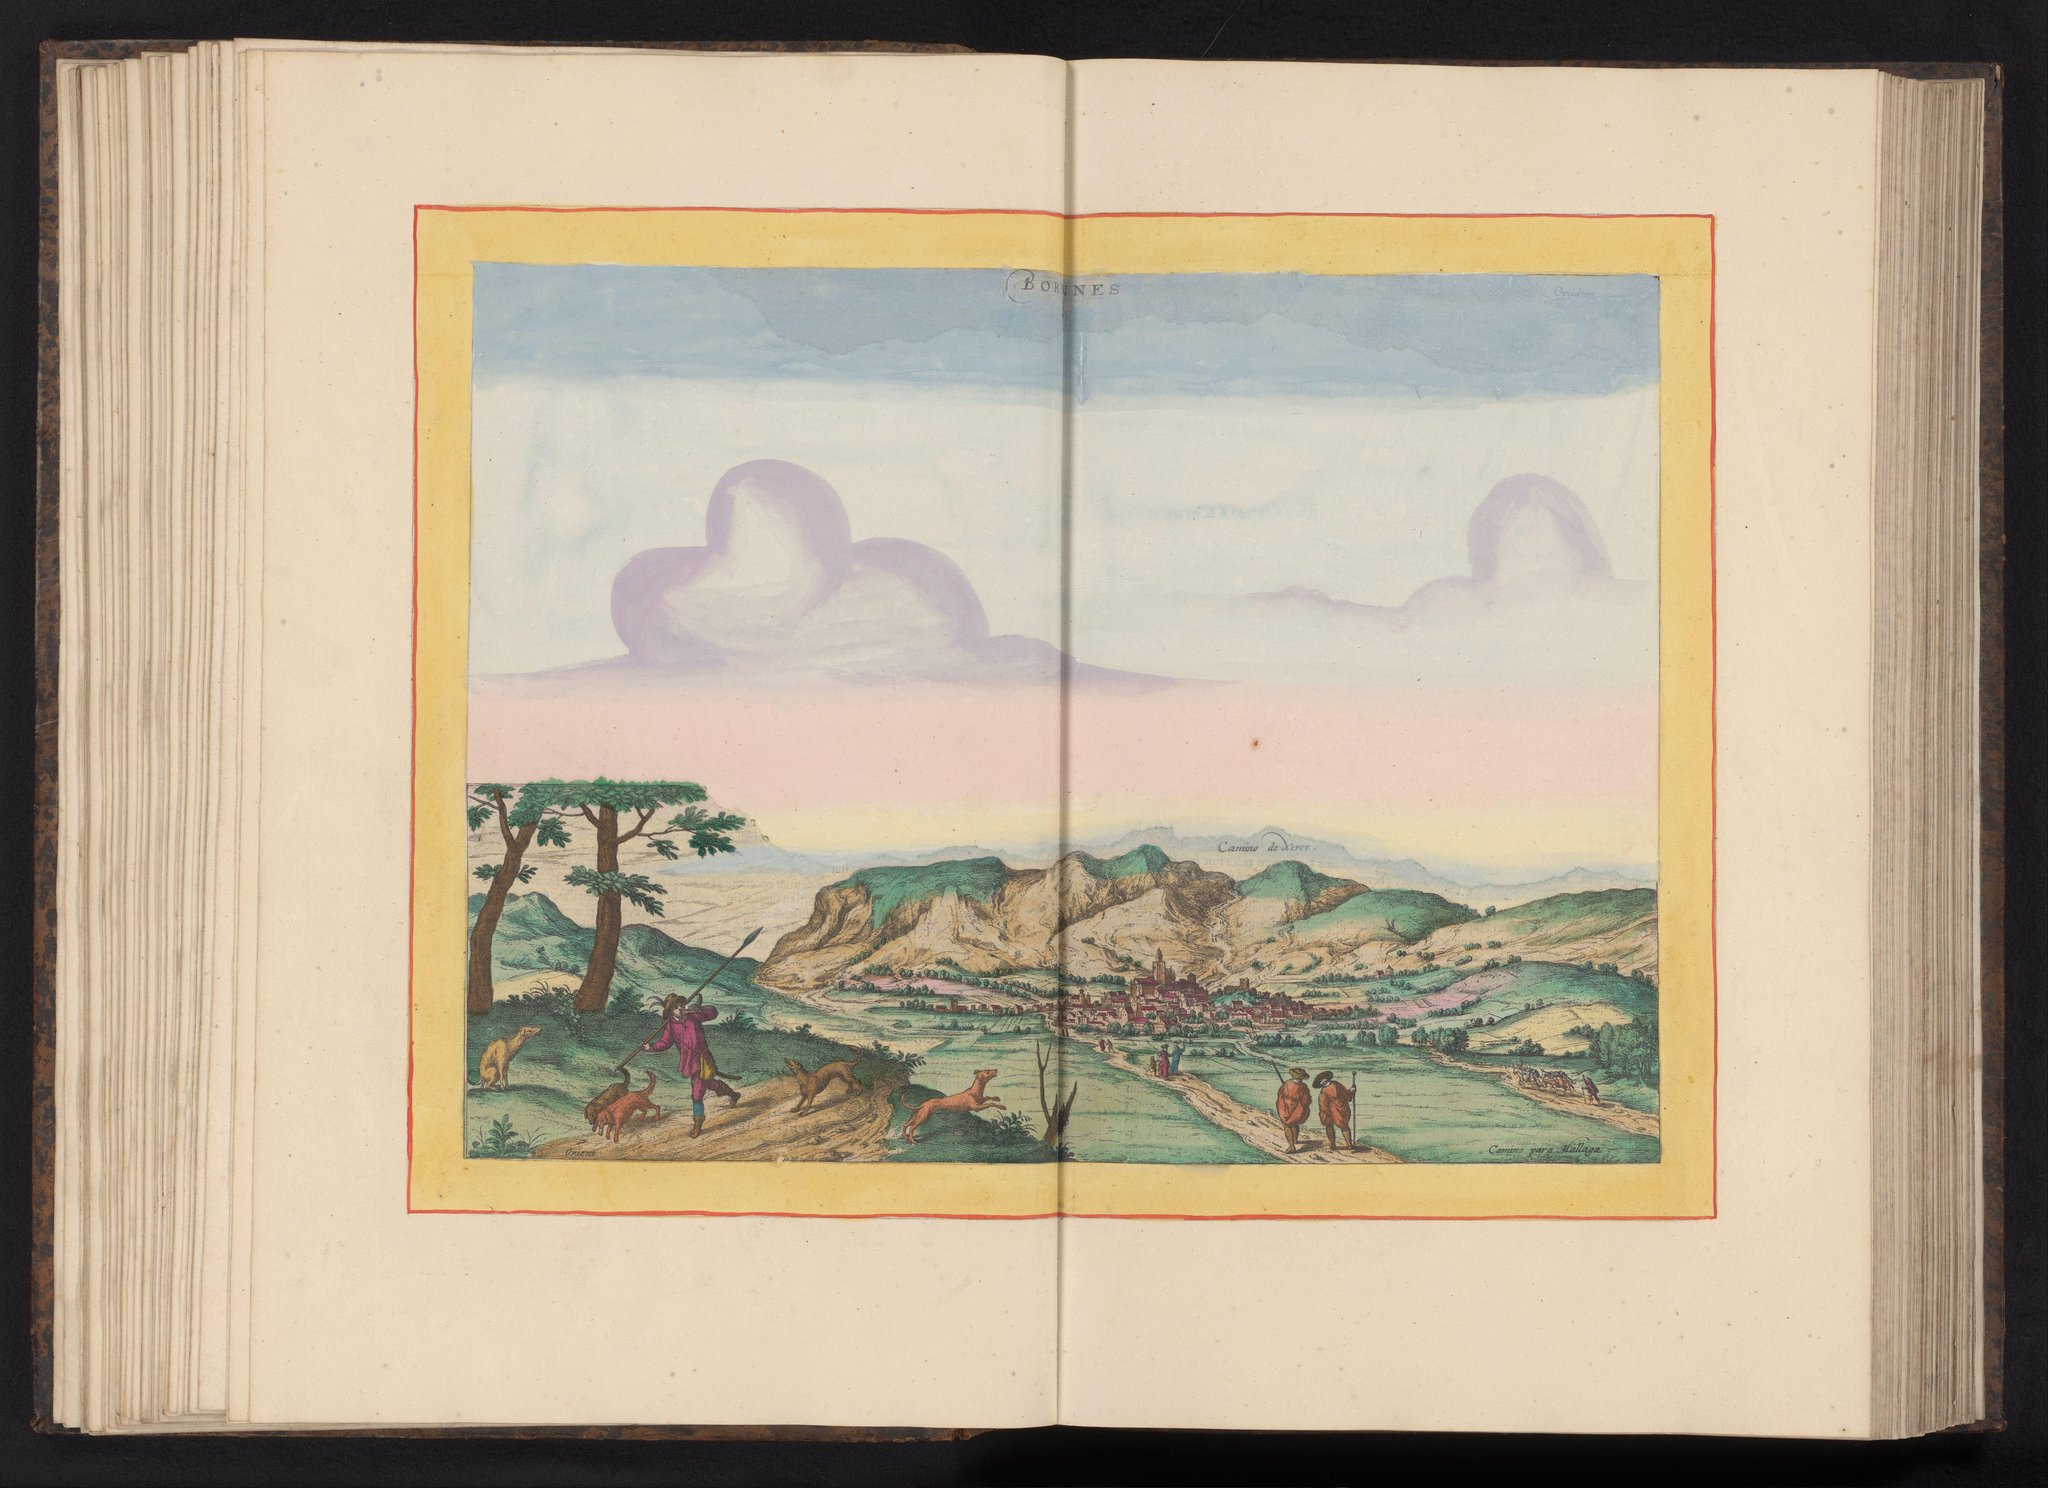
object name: album leaf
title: Bornnes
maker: anna beeck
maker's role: publisher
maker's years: 1657-1717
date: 1596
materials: paper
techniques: engraving, etching, hand coloring, letterpress printing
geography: the hague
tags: city-view in general; 'veduta'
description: Prent origineel vervaardigd als boekillustratie voor: Georg Braun en Frans Hogenberg. Civitates Orbis Terrarum, 6 delen. Keulen: 1572-1617. De prent werd voor het eerst gepubliceerd in deel 5: Urbium praecipuarum mundi theatrum quintum, 1596. De prent is langs de bovenrand van de heuvels afgescheurd. Het bovenste gedeelte met de lucht is hoger opgeplakt, zodat de lucht hoger is geworden en het formaat van de voorstelling past bij de andere groot formaatvoorstellingen in het album.